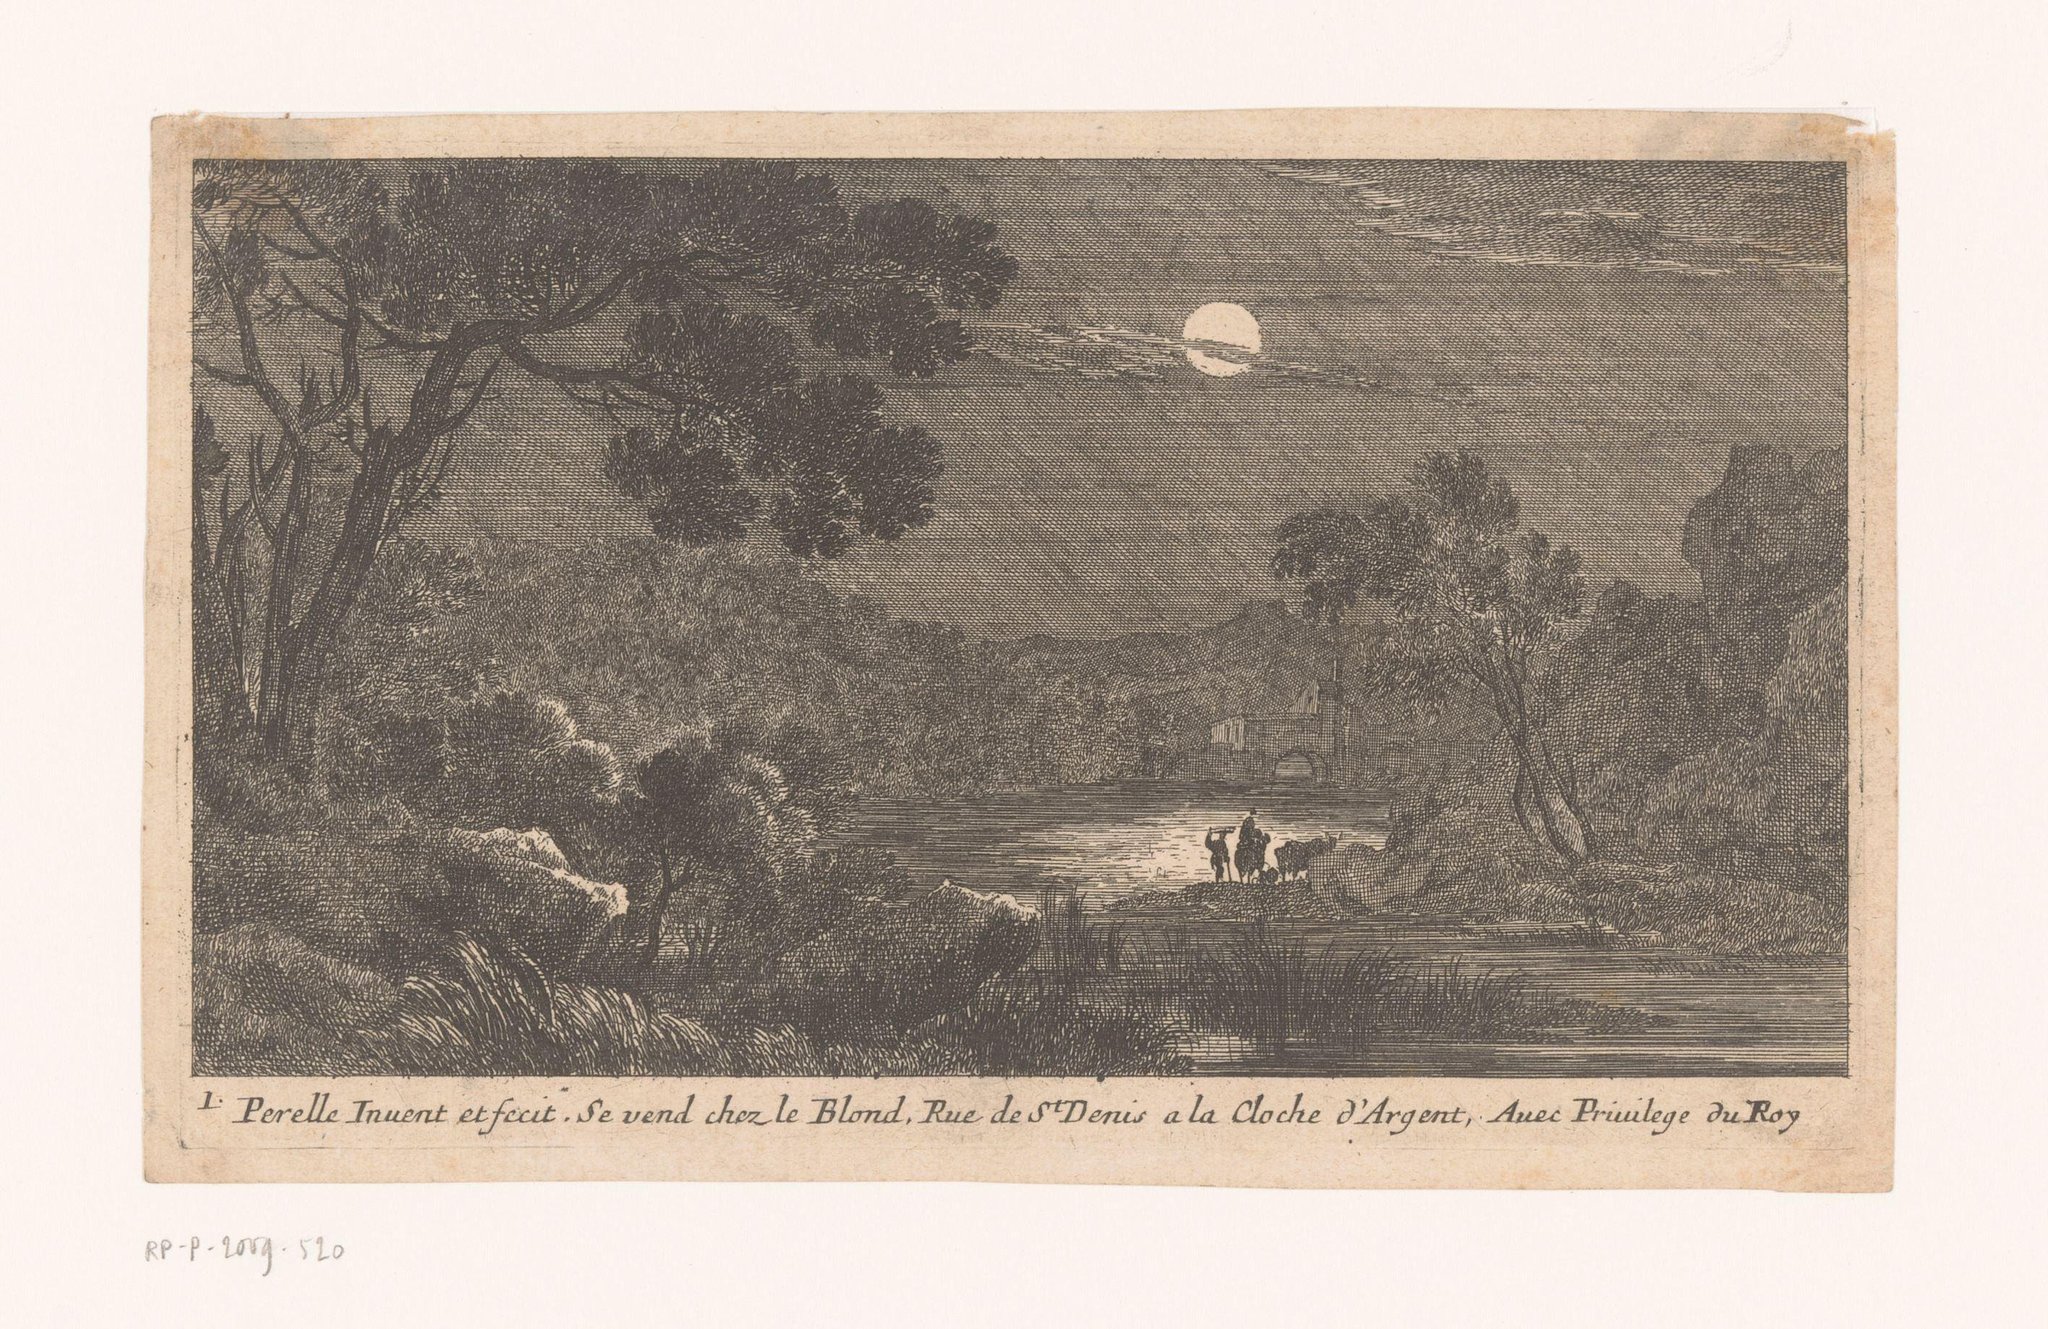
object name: print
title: Landschap bij nacht met reizigers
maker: jean leblond (i)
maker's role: publisher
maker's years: 1590-1666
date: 1620-1666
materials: paper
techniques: etching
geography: france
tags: night ~ landscape (sometimes titled 'nox'), 'en route', traveller under way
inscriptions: collector's mark: Lugt 2228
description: Landschap bij nacht, met rivier bij volle maan. Op een pad twee figuren op de rug gezien waarvan één zittend op paard, voor hen uit lopend een koe.